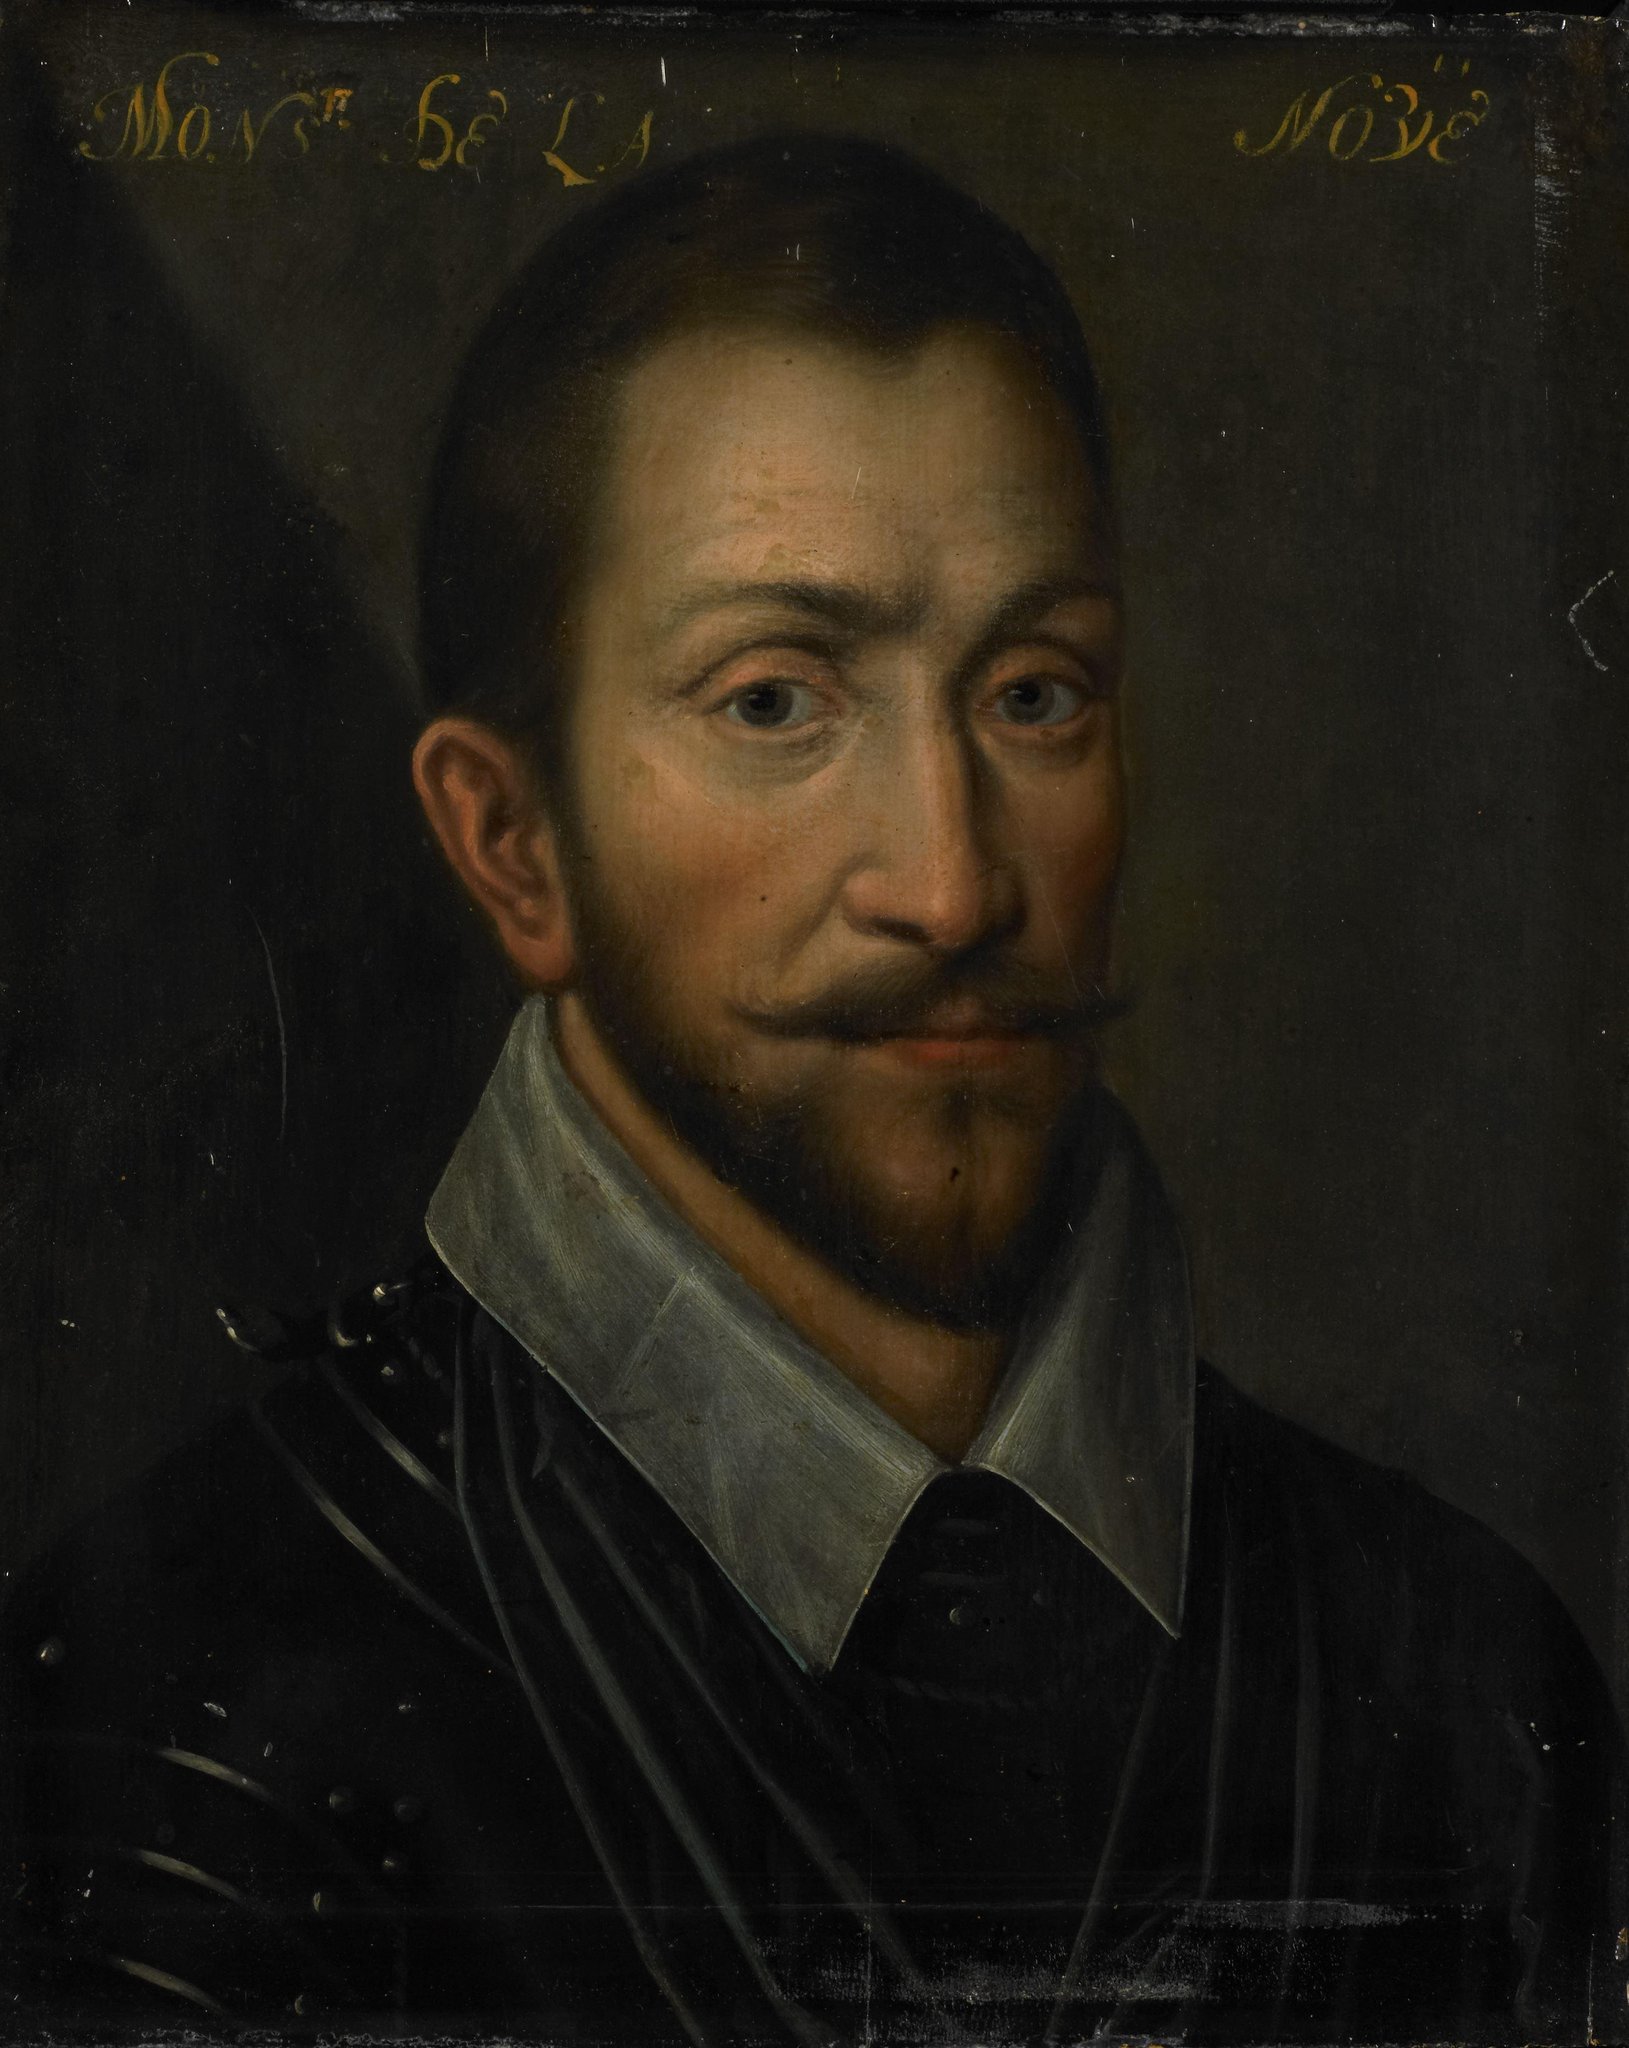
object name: painting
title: Portrait of François de la Noue (1531-91), Lord of Teligny, called ‘Bras de Fer’ and ‘le Bayard Huguenot’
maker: Anonymous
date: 1609-1633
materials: oil, panel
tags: historical persons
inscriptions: inscription, top: ‘Mons.r de la Noue’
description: Vermoedelijk François de la Noue, heer van Teligny (1531-1591), anoniem.